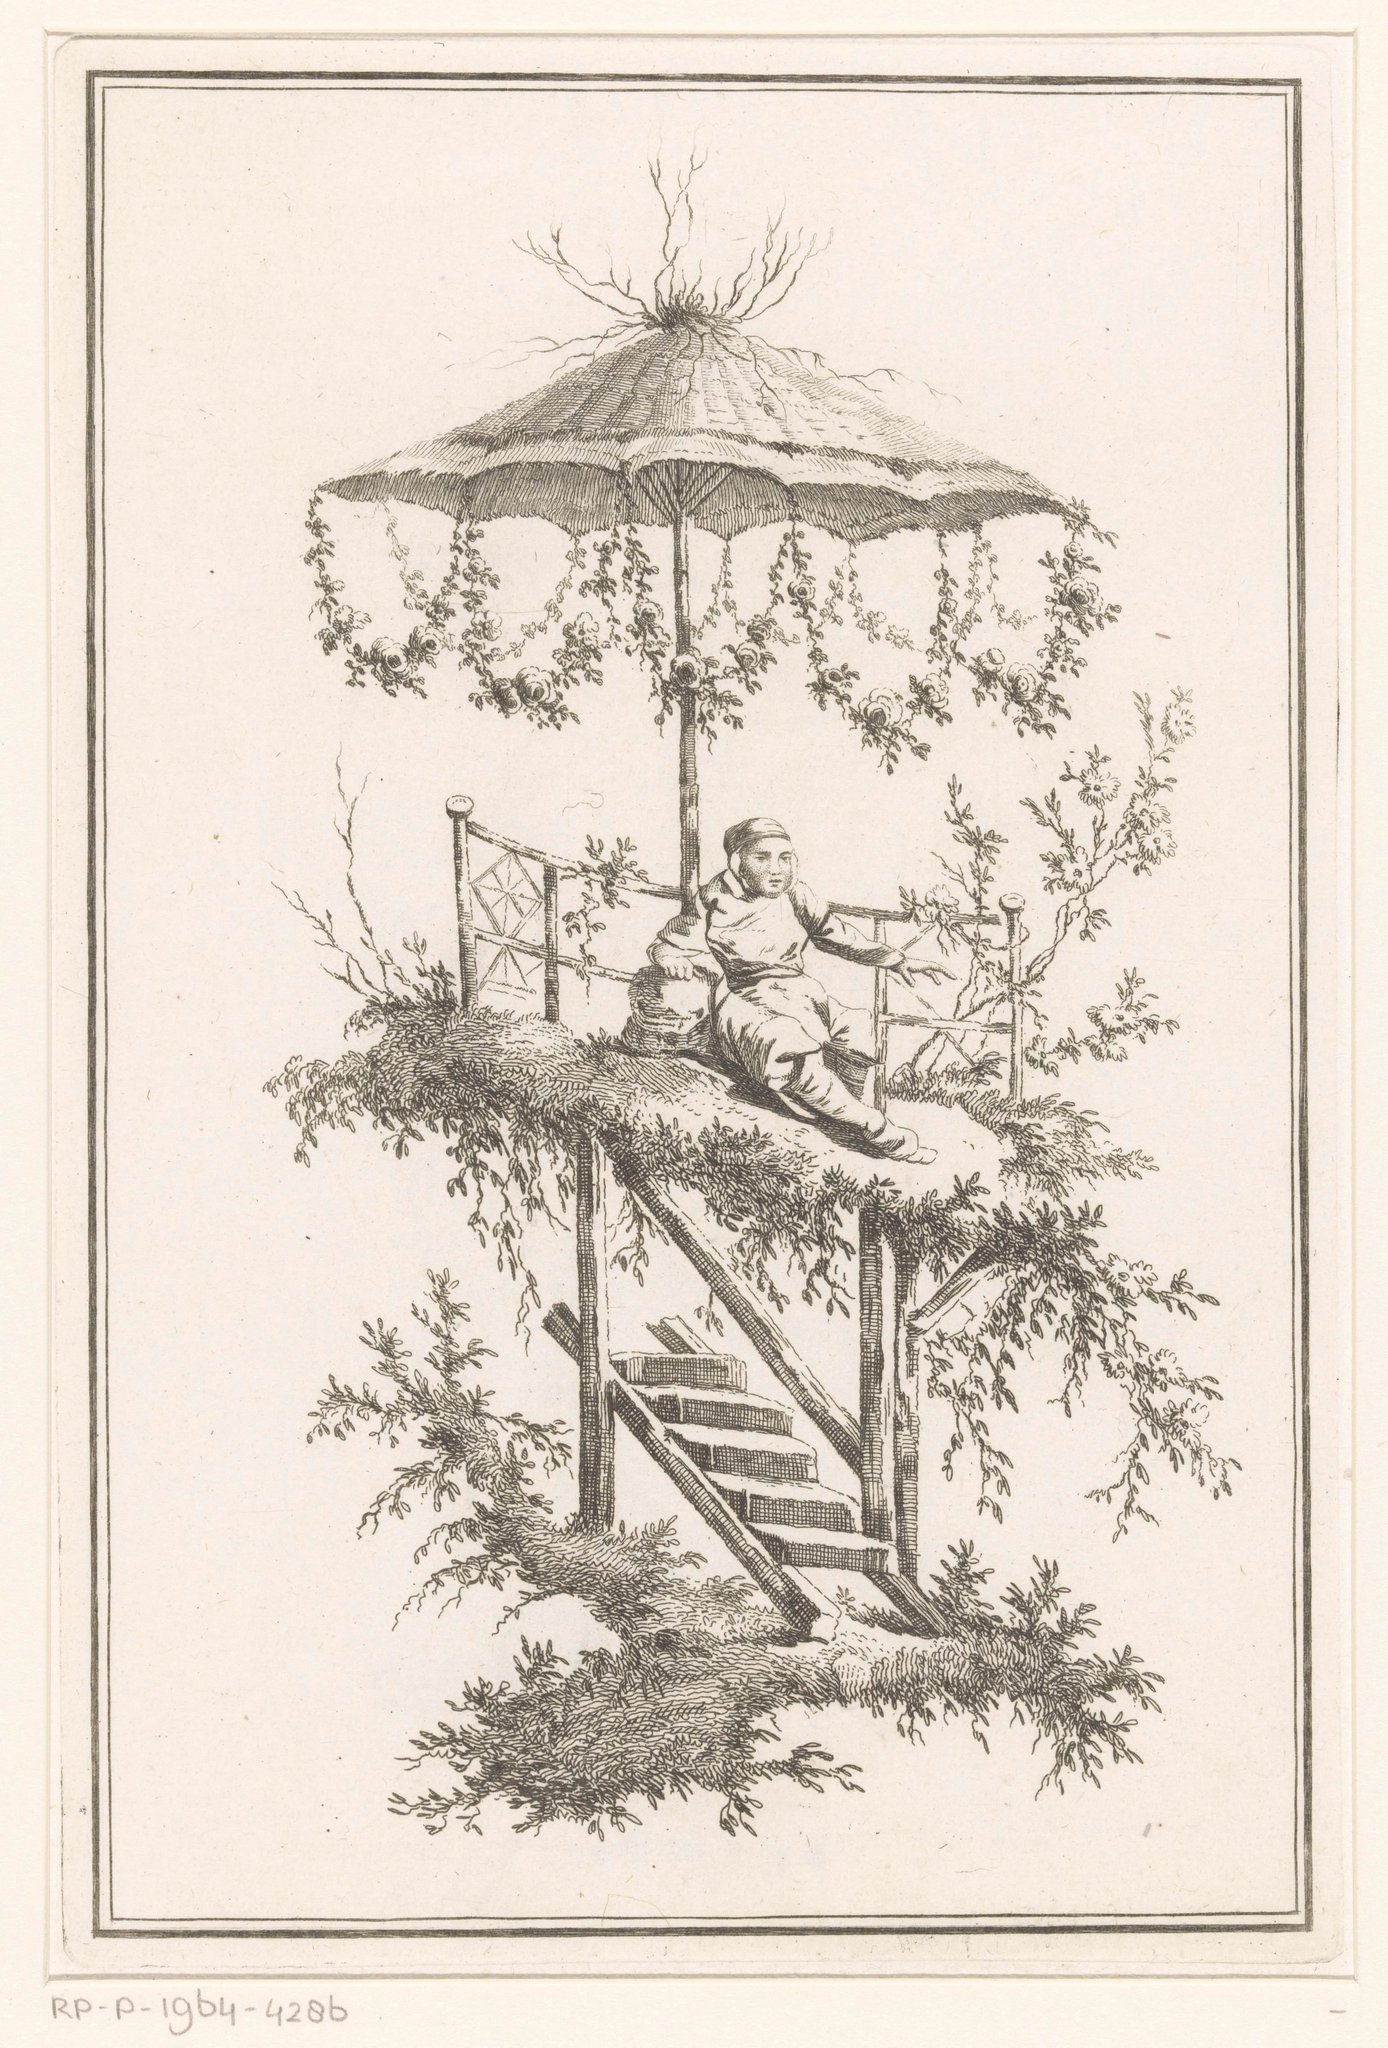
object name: print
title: Man onder parasol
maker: jean jacques avril (i)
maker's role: print maker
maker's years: 1744-1831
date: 1773-1774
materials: paper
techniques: etching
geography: paris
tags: sitting figure, parasol, sunshade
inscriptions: collector's mark: Lugt 2228, collector's mark: Lugt 2760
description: In een landschap zit een man onder een parasol met guirlandes, onder hem een trap.